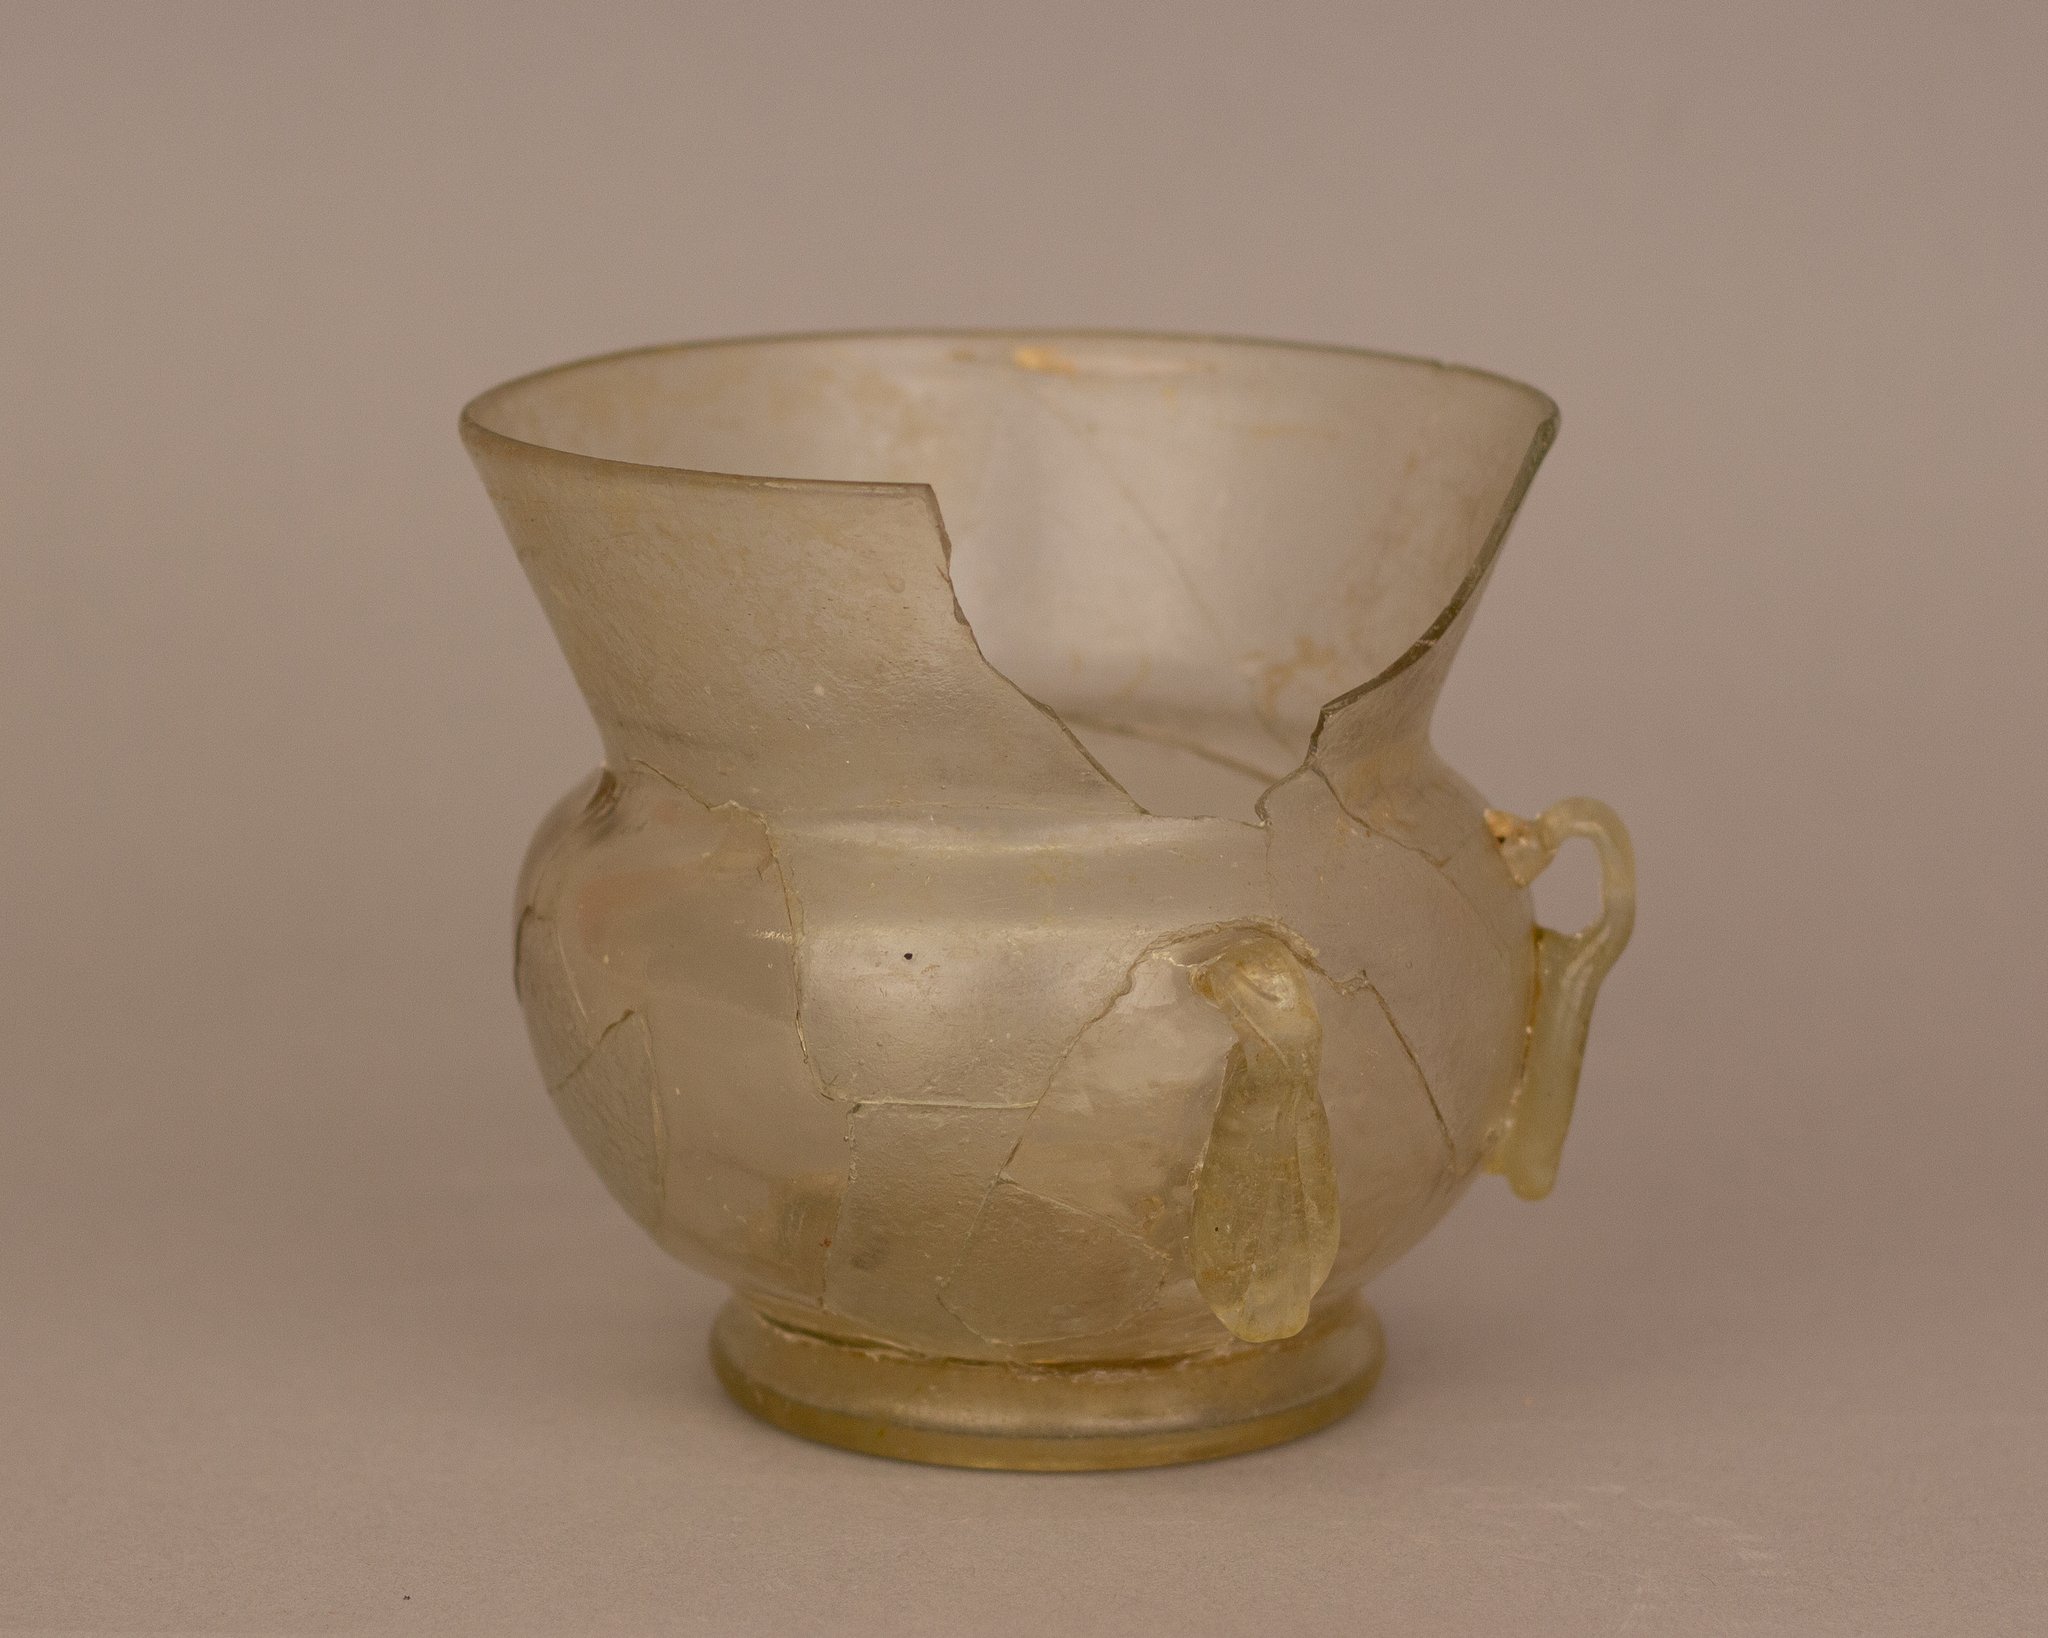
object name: fragment of a mosque lamp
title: Fragments of a Lamp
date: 901-1200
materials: glass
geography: iran